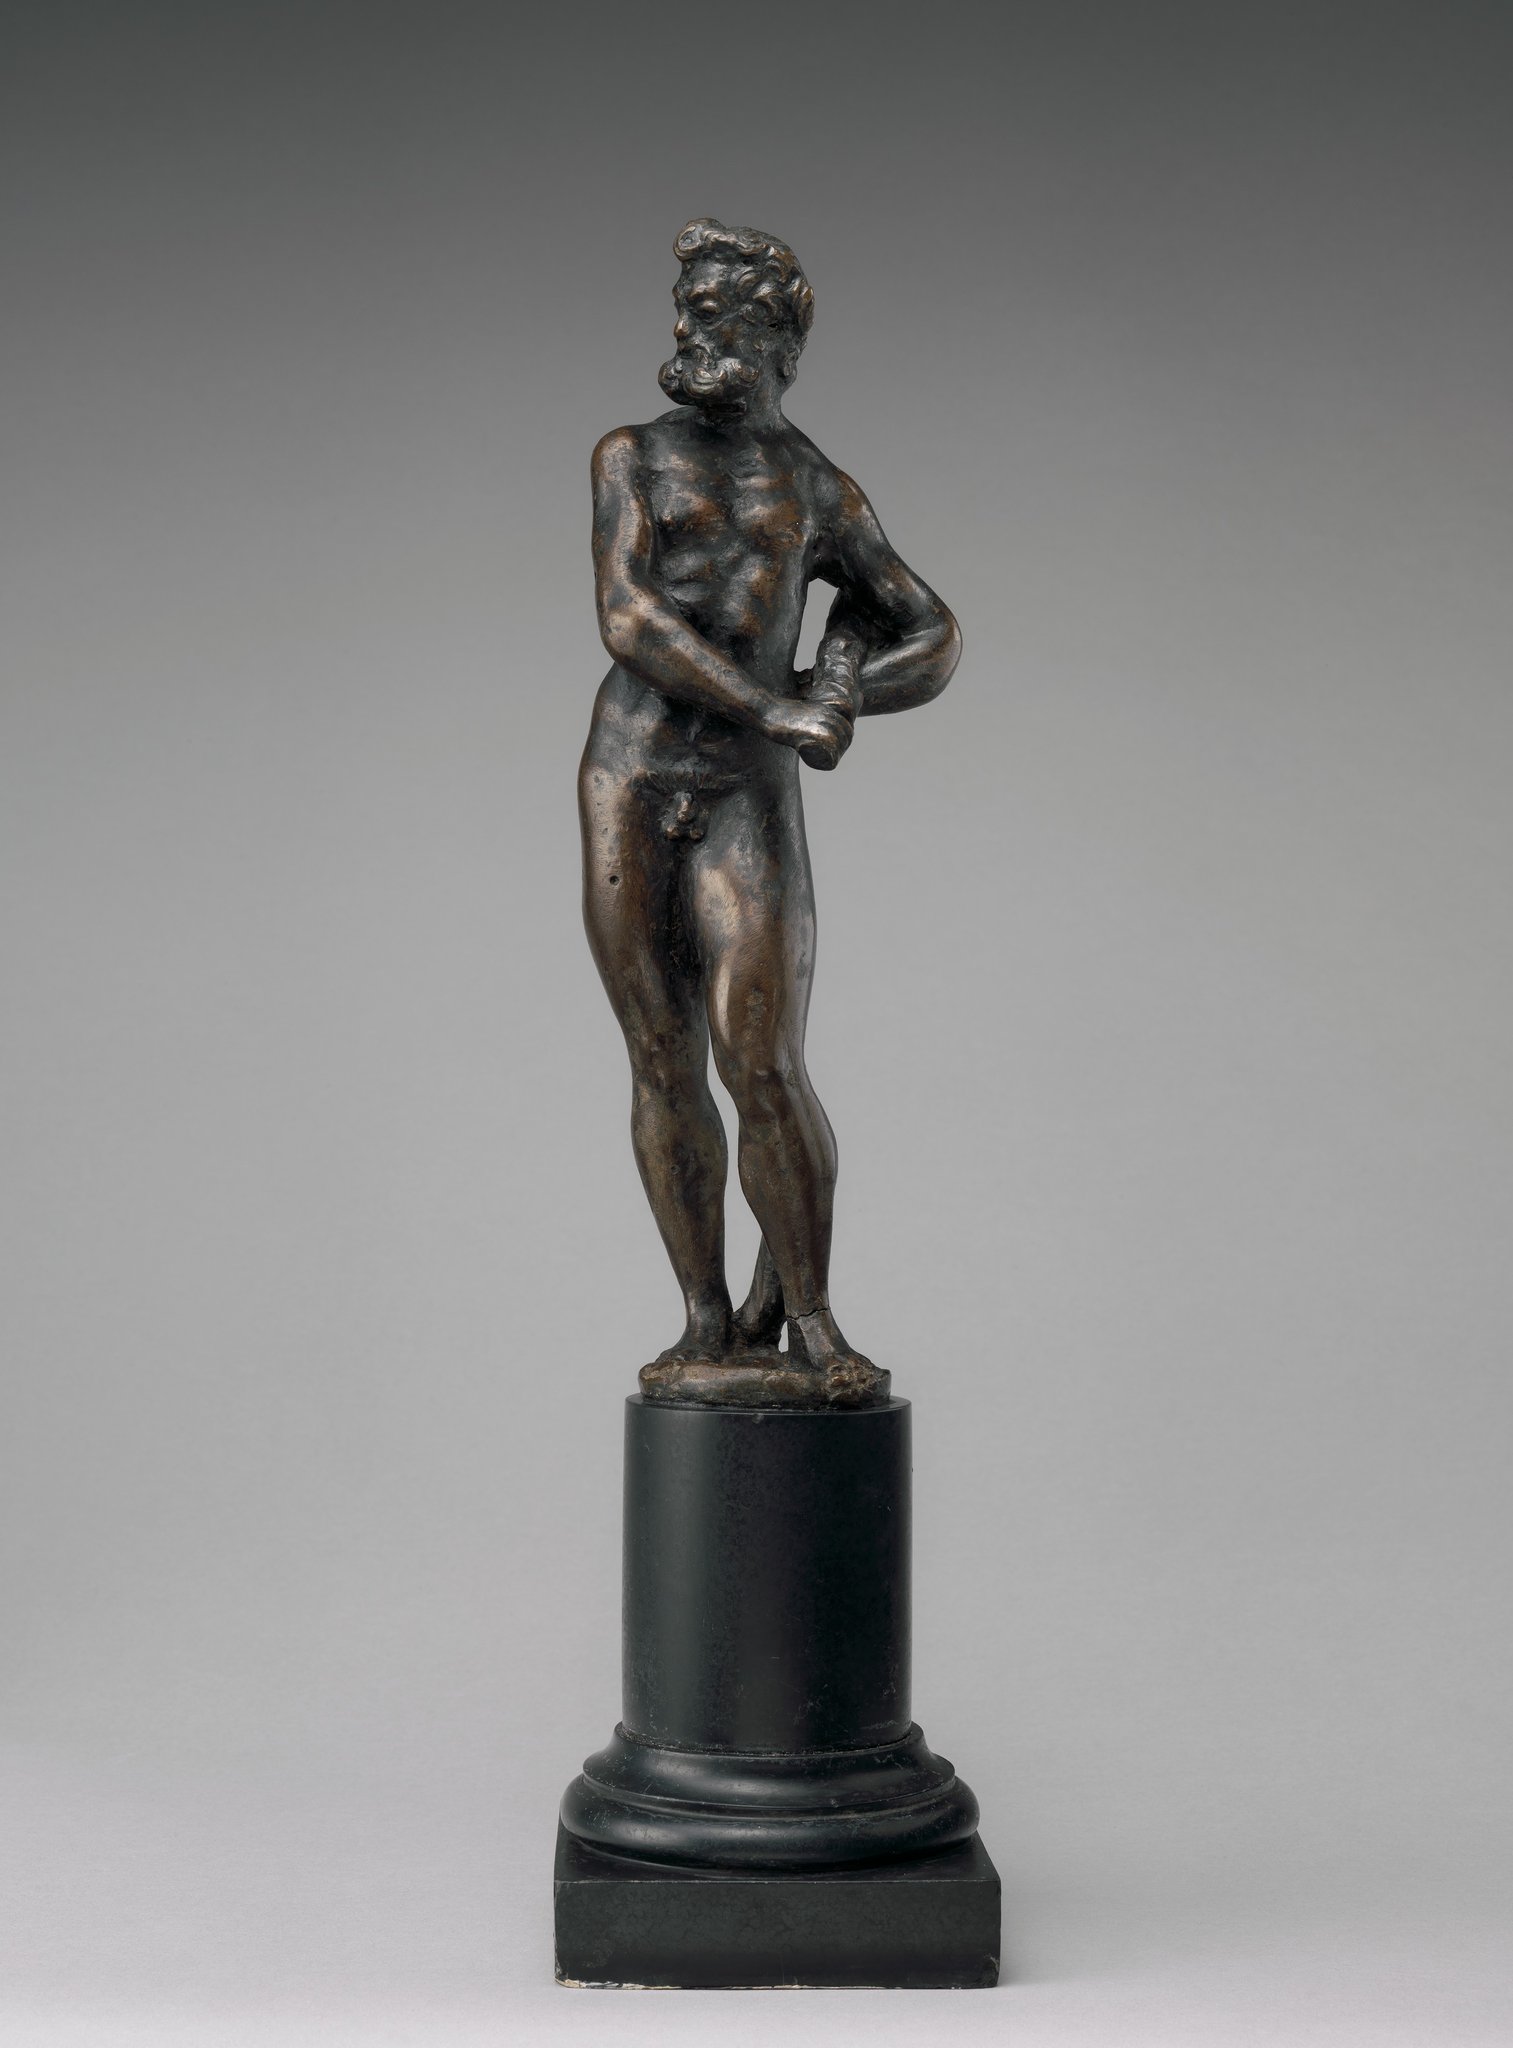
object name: statuette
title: Hercules carrying his club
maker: niccolò roccatagliata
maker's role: artist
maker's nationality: italian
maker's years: 1593-1636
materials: bronze, stone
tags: hercules